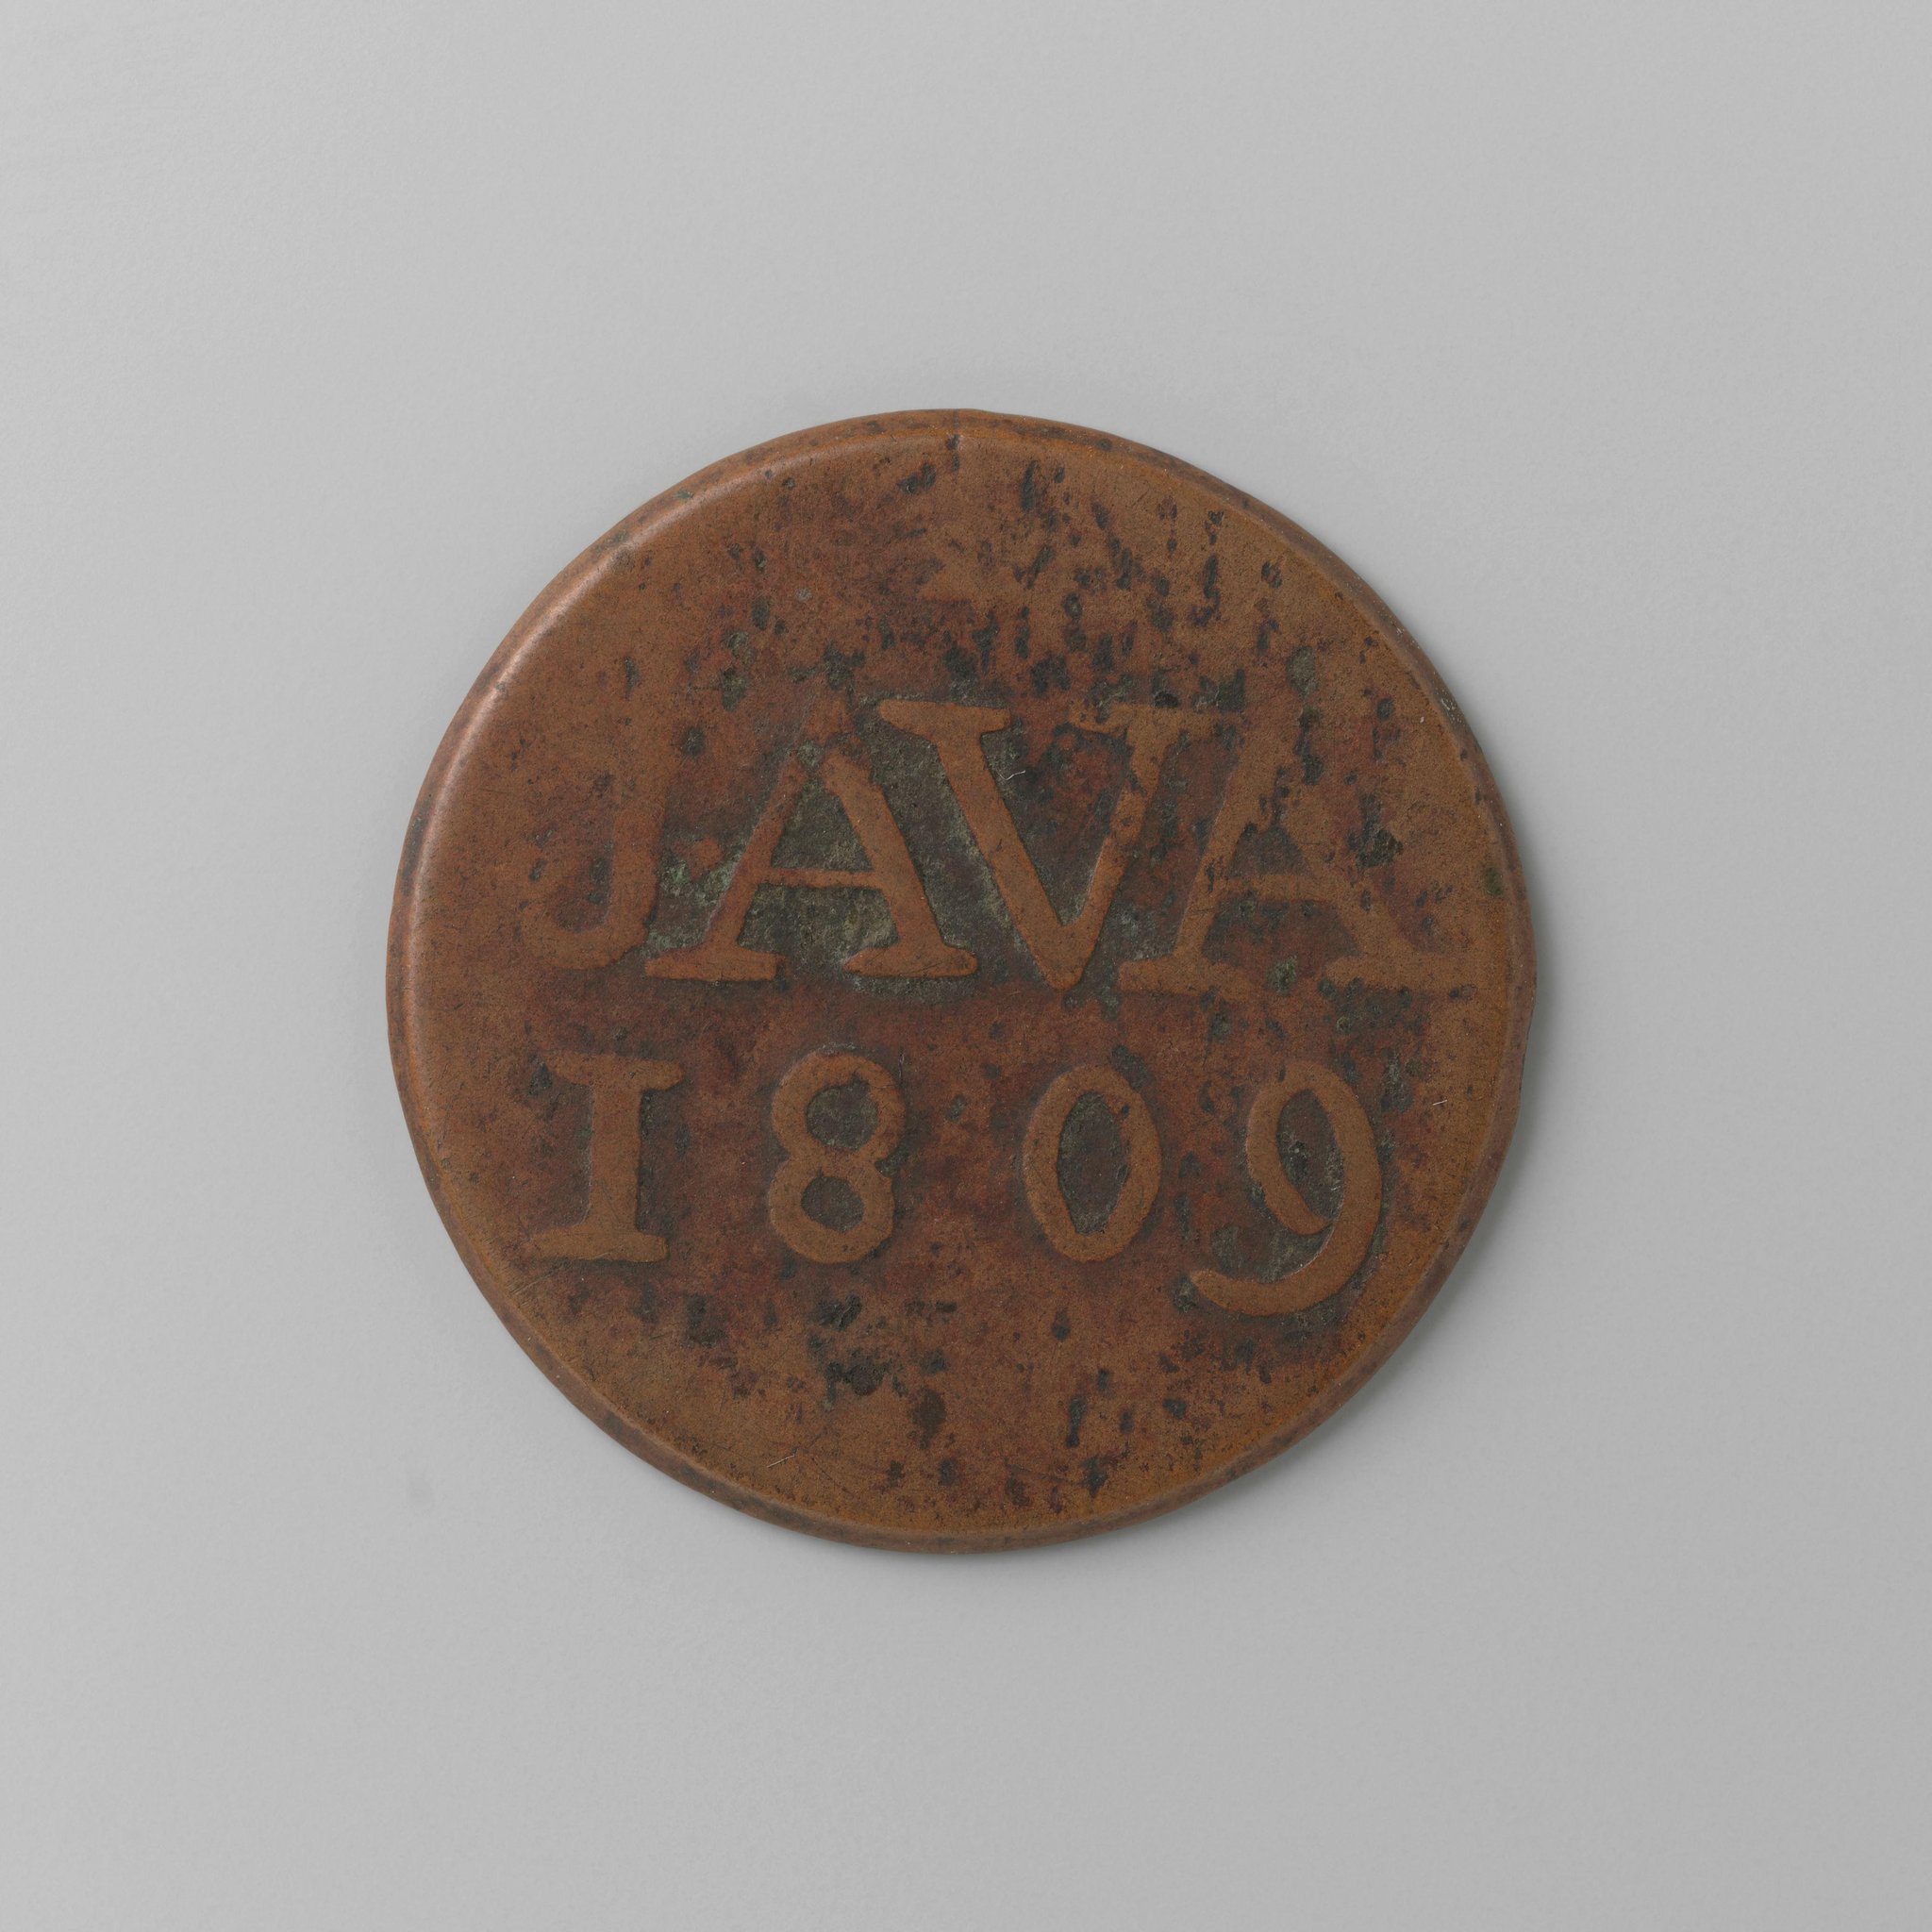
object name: coin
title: Nederlands Indië, duit Java,1809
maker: louis napoleon (king of holland)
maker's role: koning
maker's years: 1778-1846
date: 1809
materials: copper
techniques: striking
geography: surabaya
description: Koperen munt. Voorzijde: opschrift, JAVA, waarboven munteken en waaronder jaartal. Keerzijde: monogram van de VOC. Daarboven muntteken. Gladde rand.